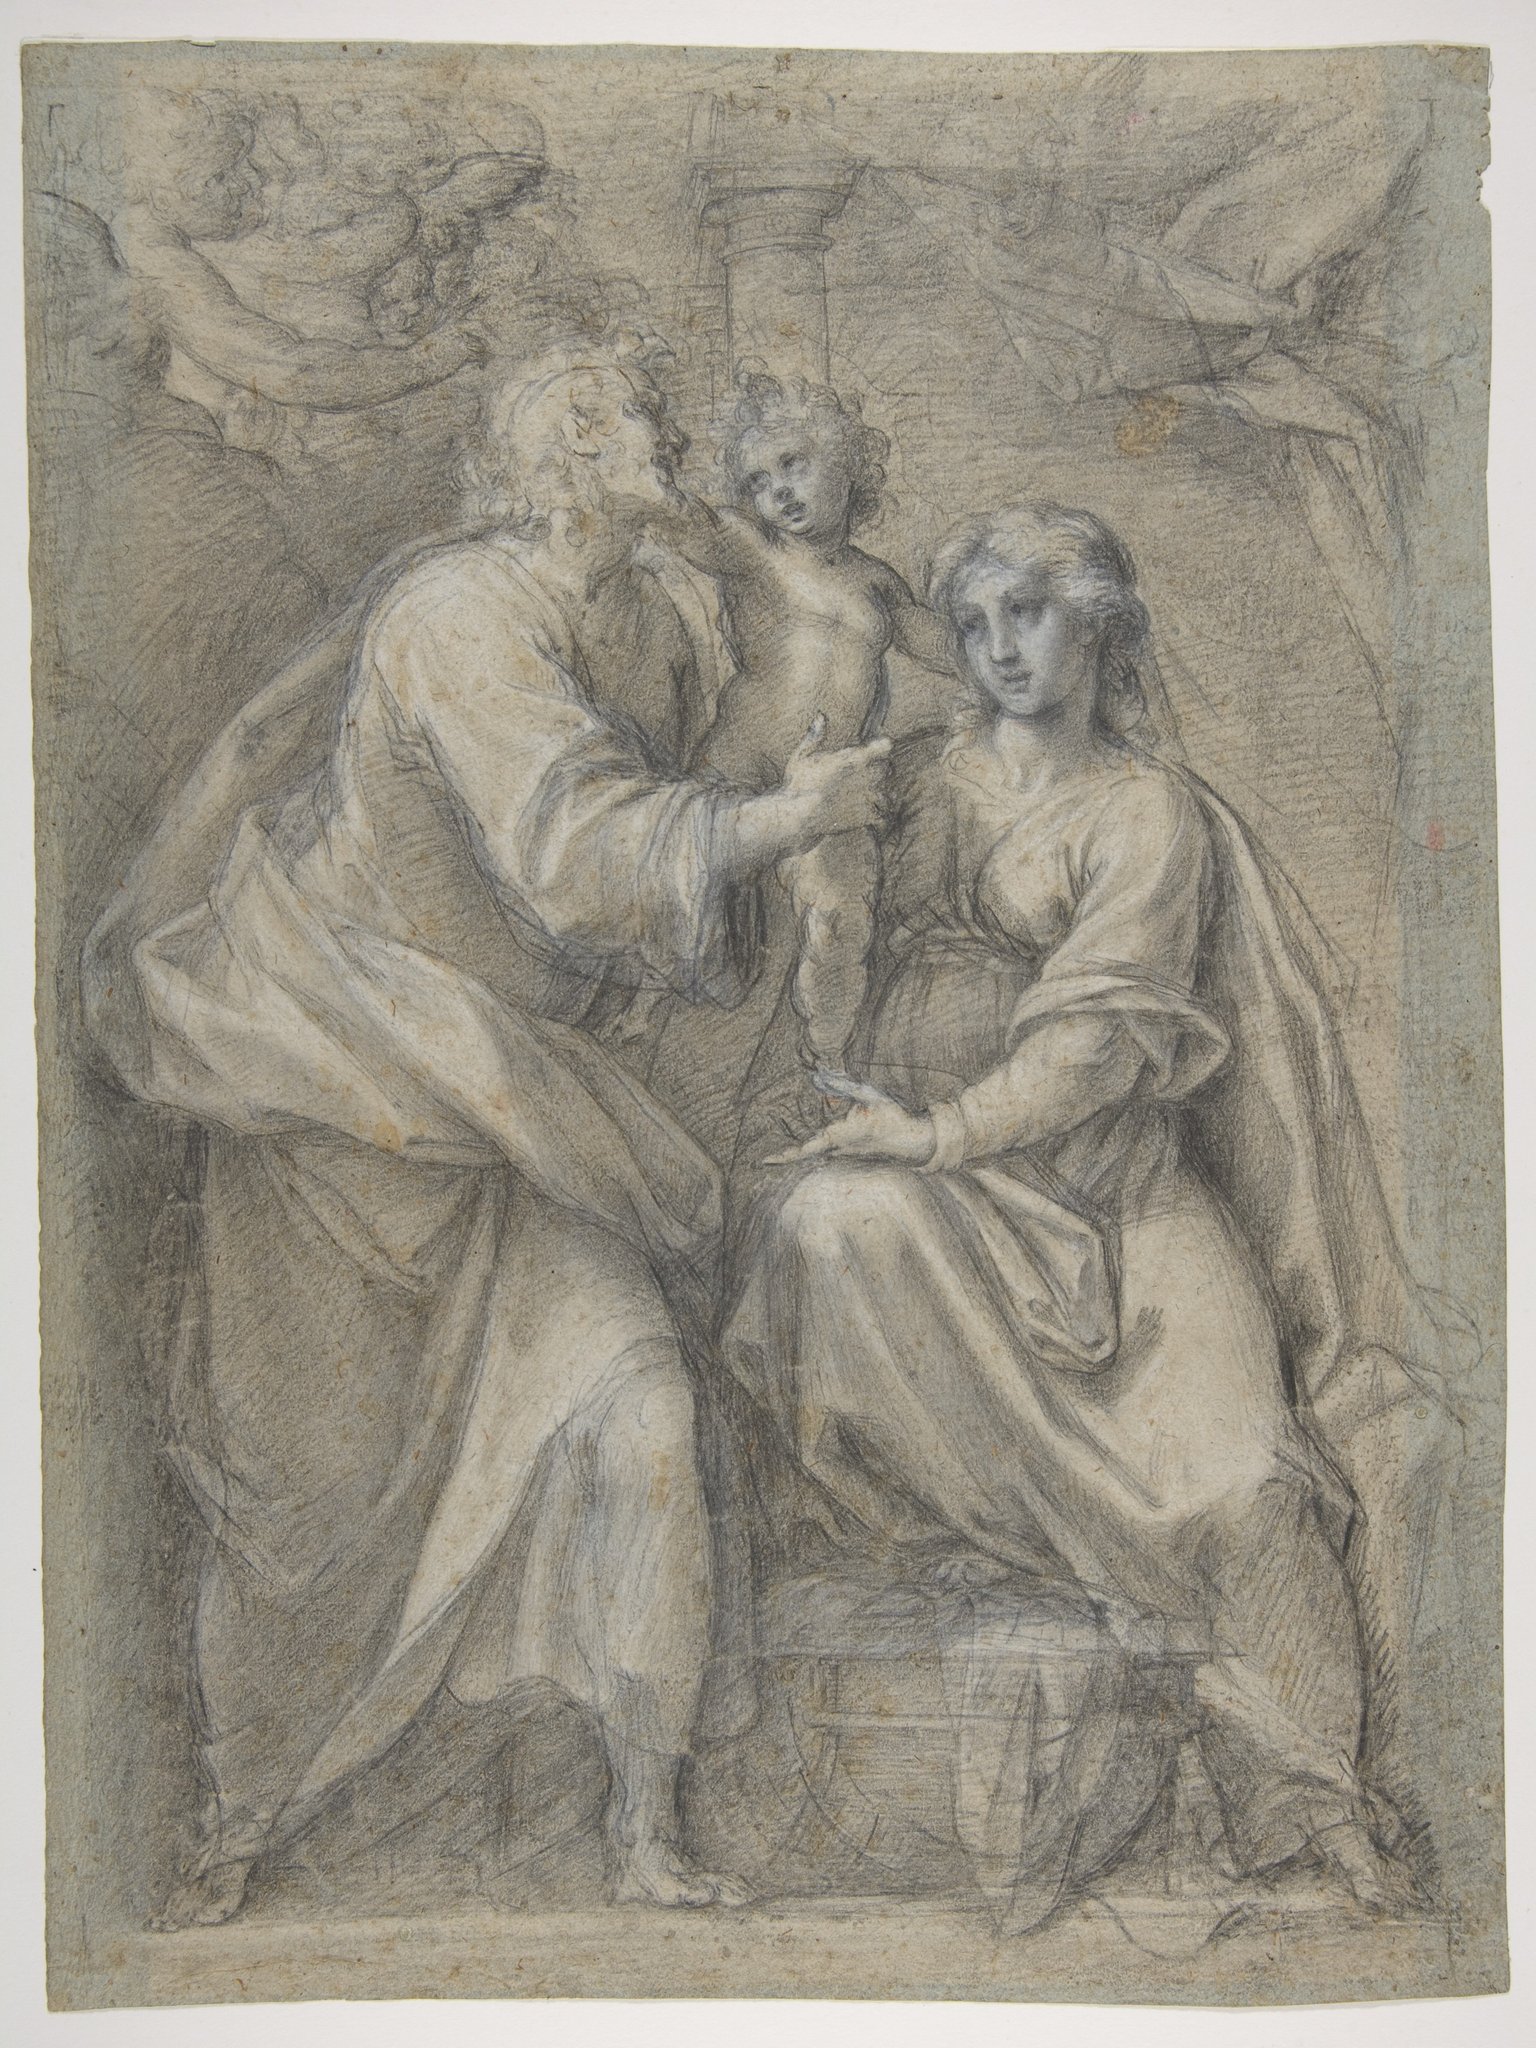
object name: drawing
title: The Holy Family with Angels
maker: pomarancio (cristoforo roncalli)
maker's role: artist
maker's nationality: italian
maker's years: 1553-1626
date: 1603-1605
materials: chalk, paper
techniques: highlighting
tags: angels,christ,holy family,virgin mary